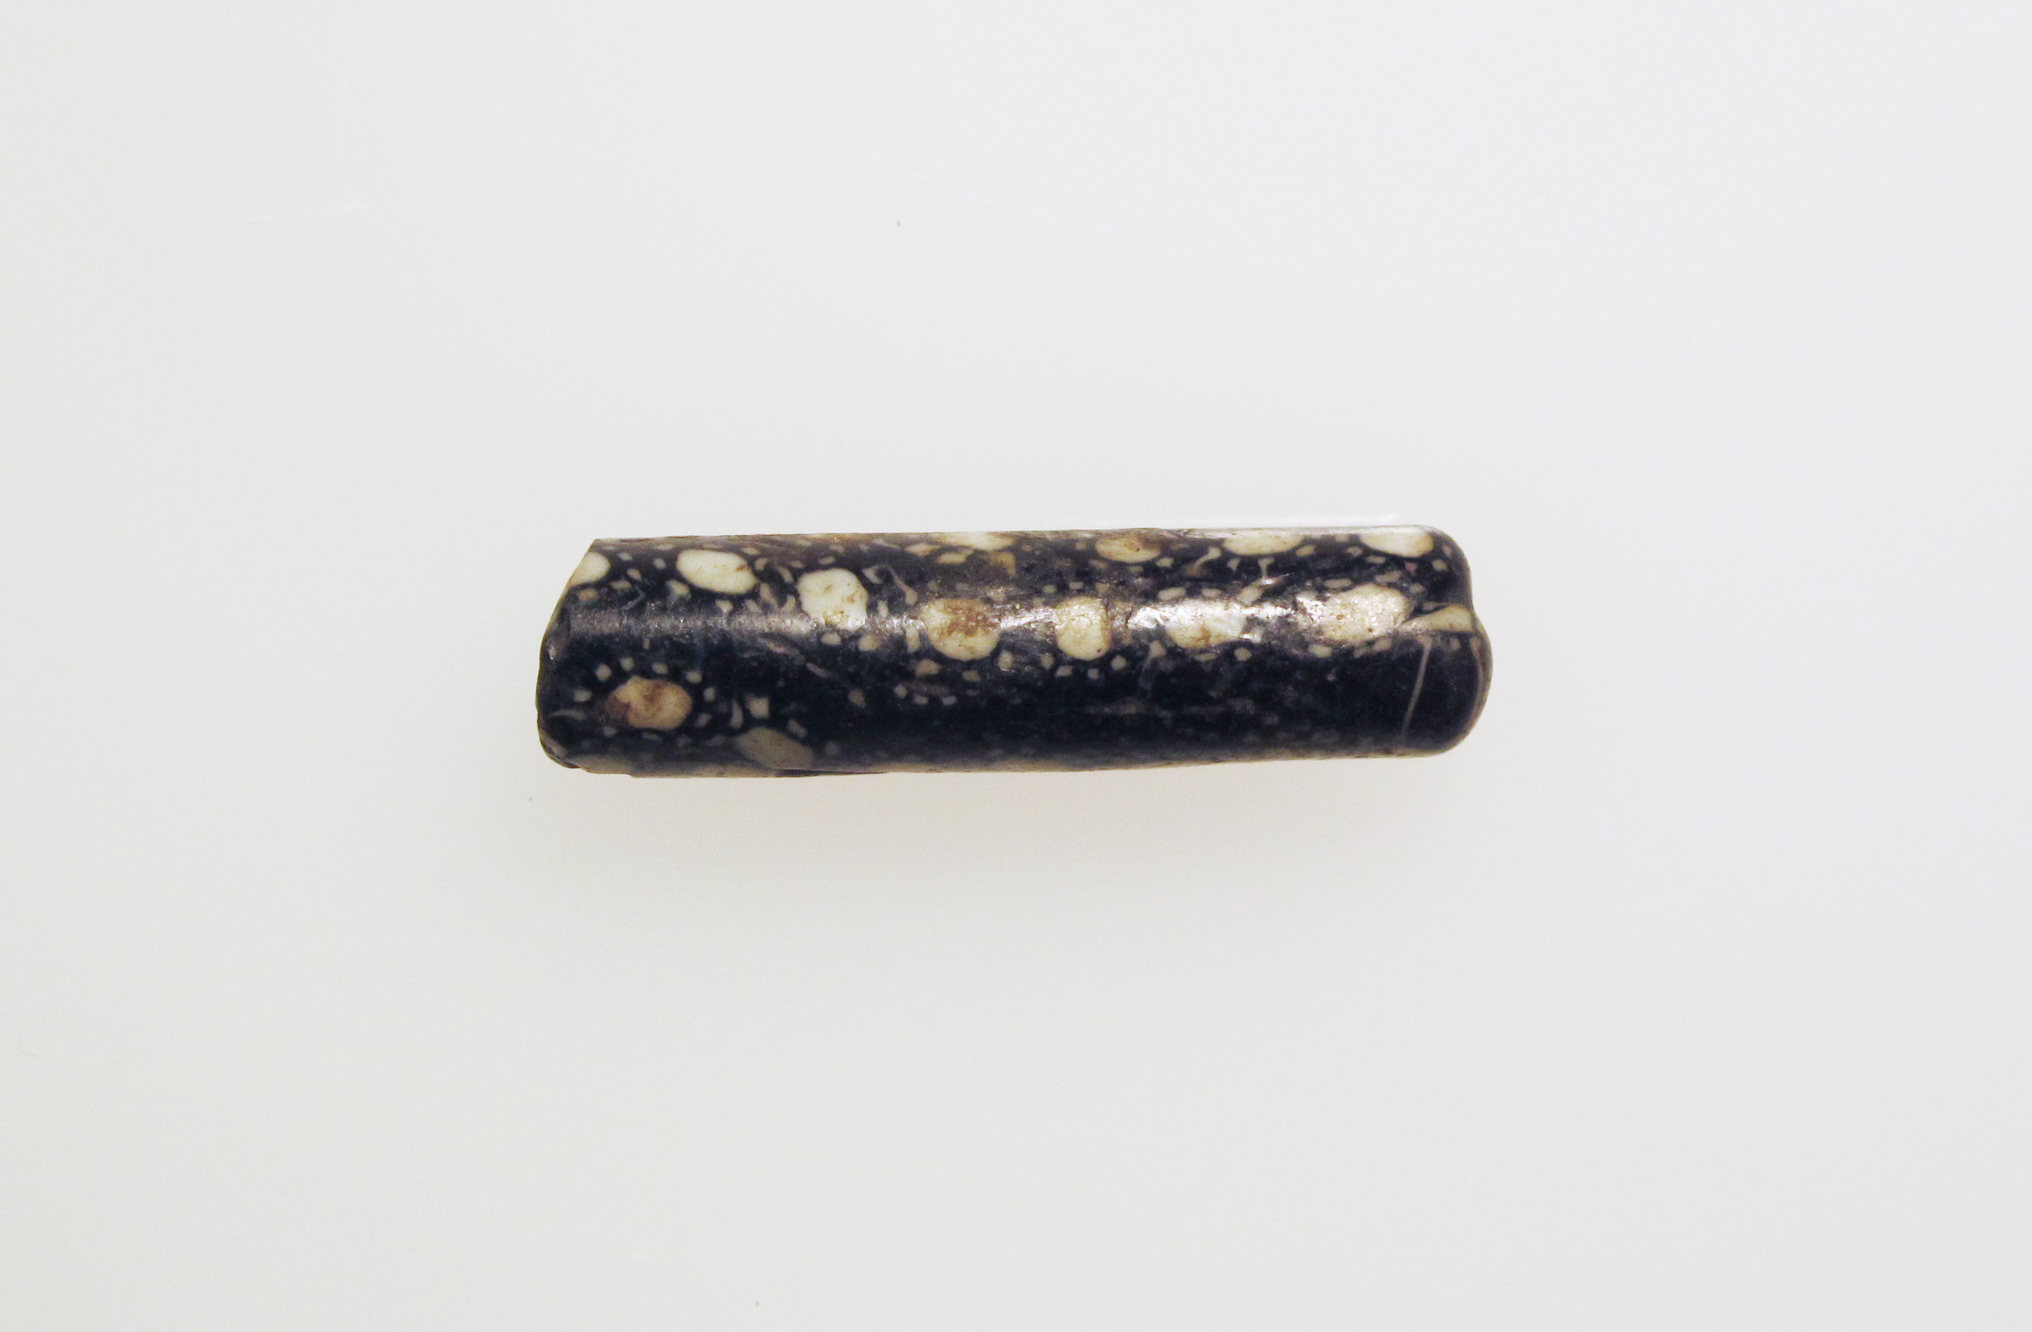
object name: bead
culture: roman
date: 670 BCE-330 CE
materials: glass